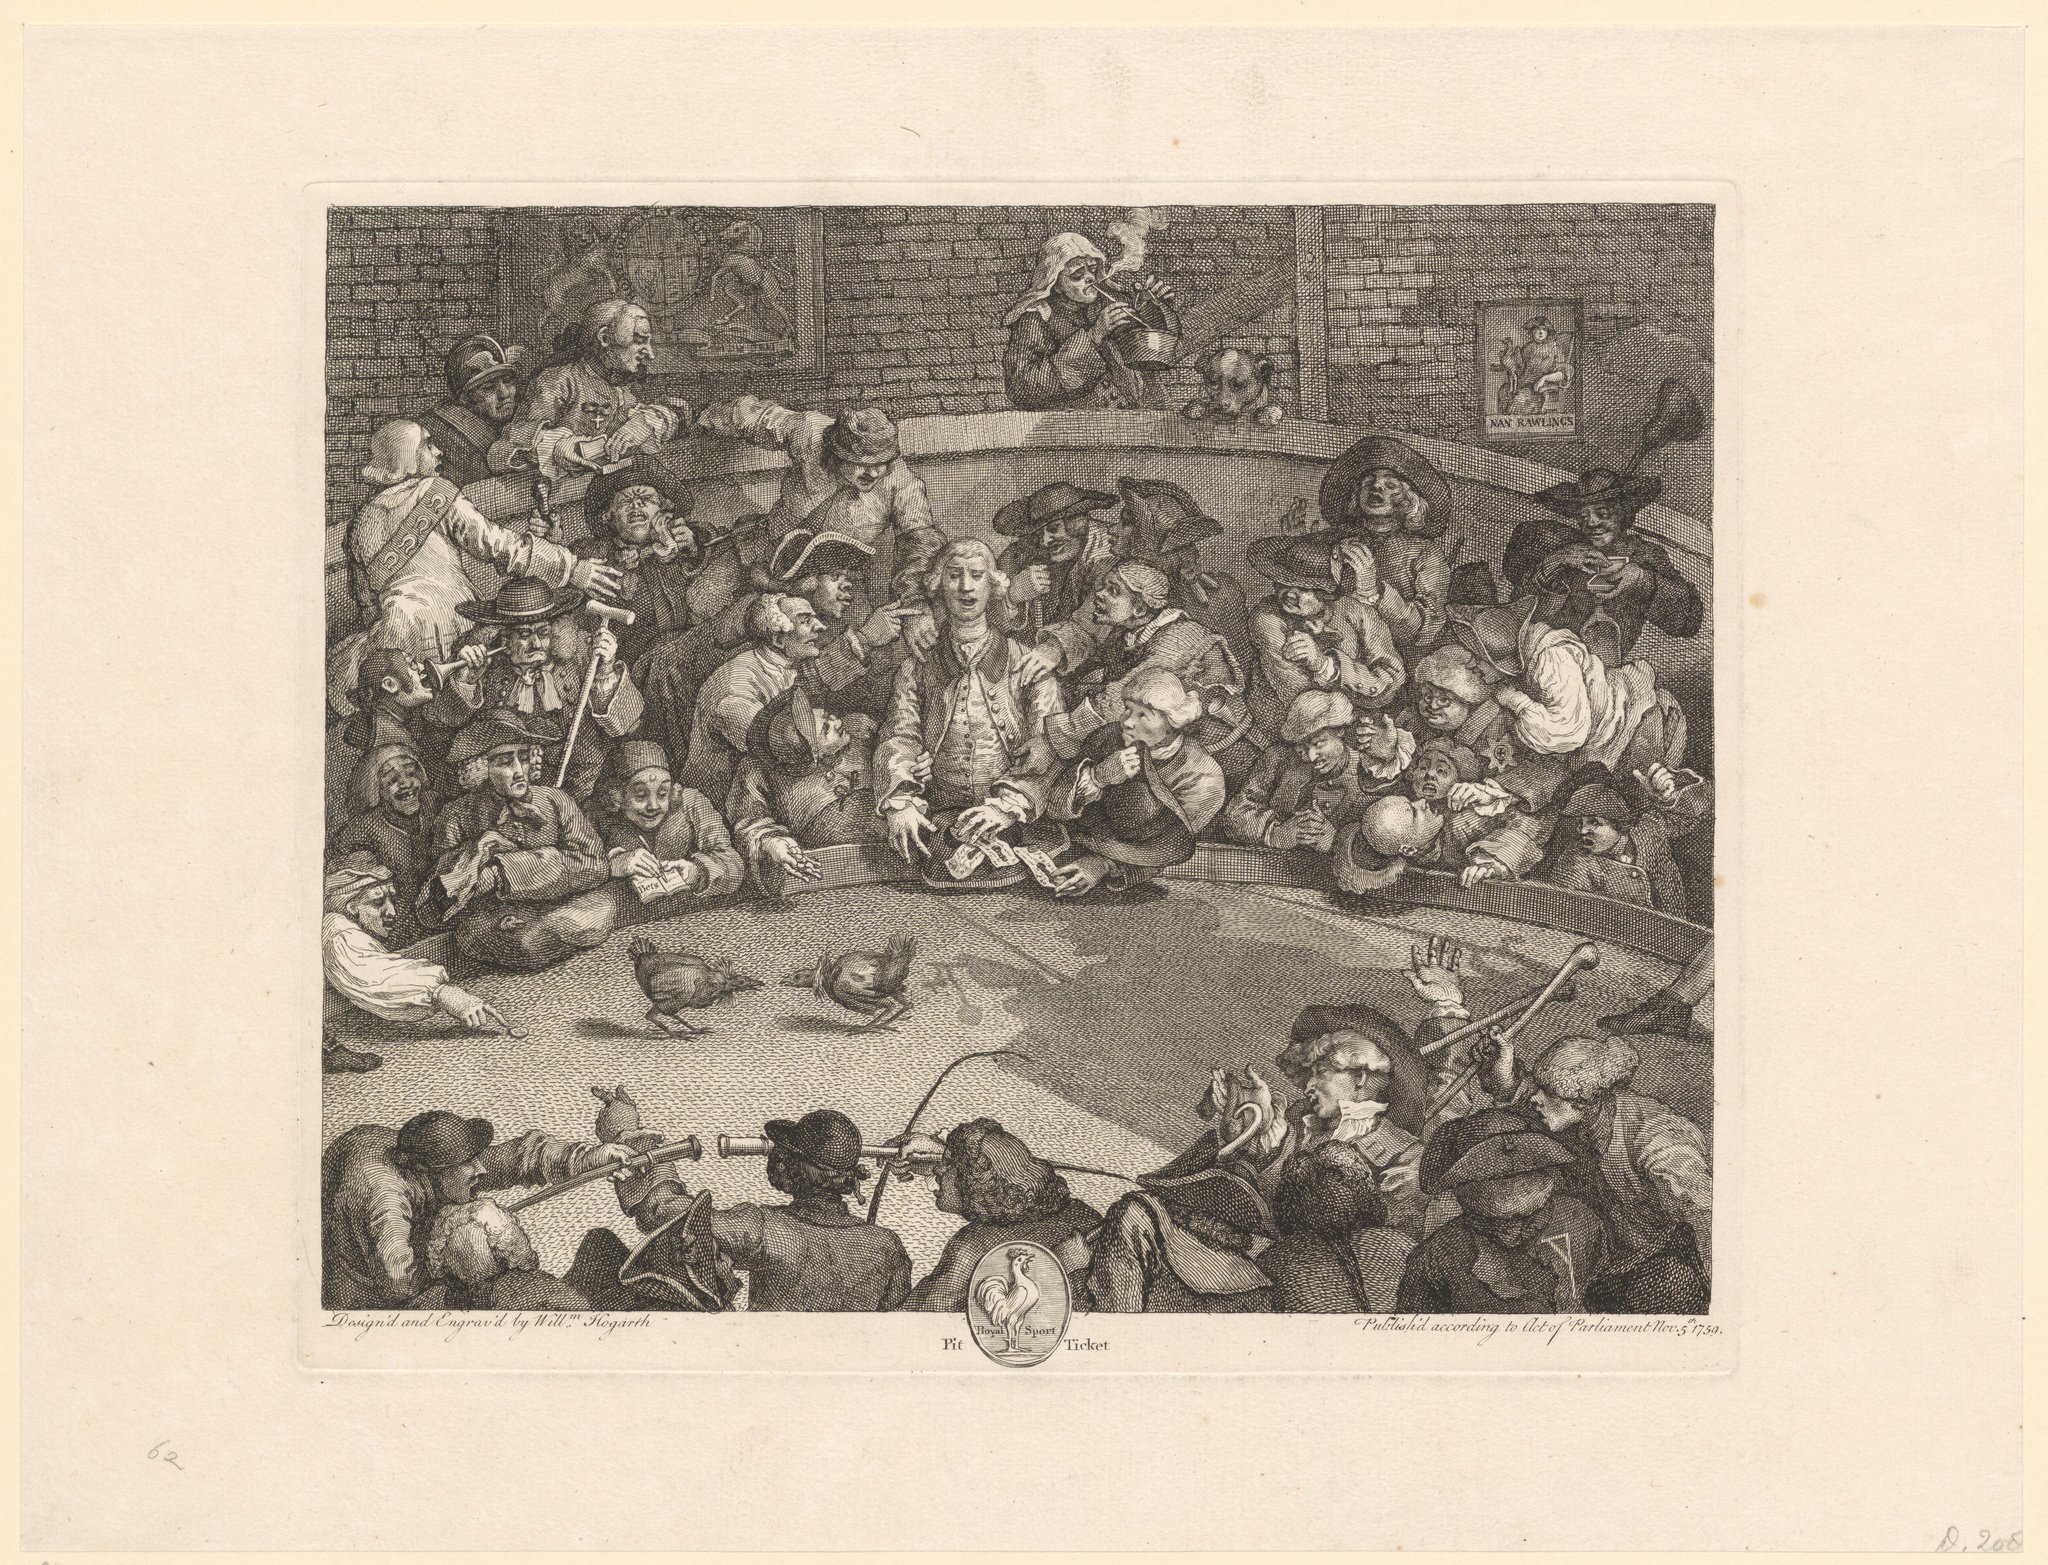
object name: print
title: The Cockpit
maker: william hogarth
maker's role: draughtsman, painter, print maker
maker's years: 1697-1764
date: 1711-1759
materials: paper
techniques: etching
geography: london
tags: betting on sports, theft, cock-fighting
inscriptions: date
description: Centraal zit de blinde Lord Albermarle Bertie, van wie geld wordt gestolen en met wie weddenschappen worden gelegd.